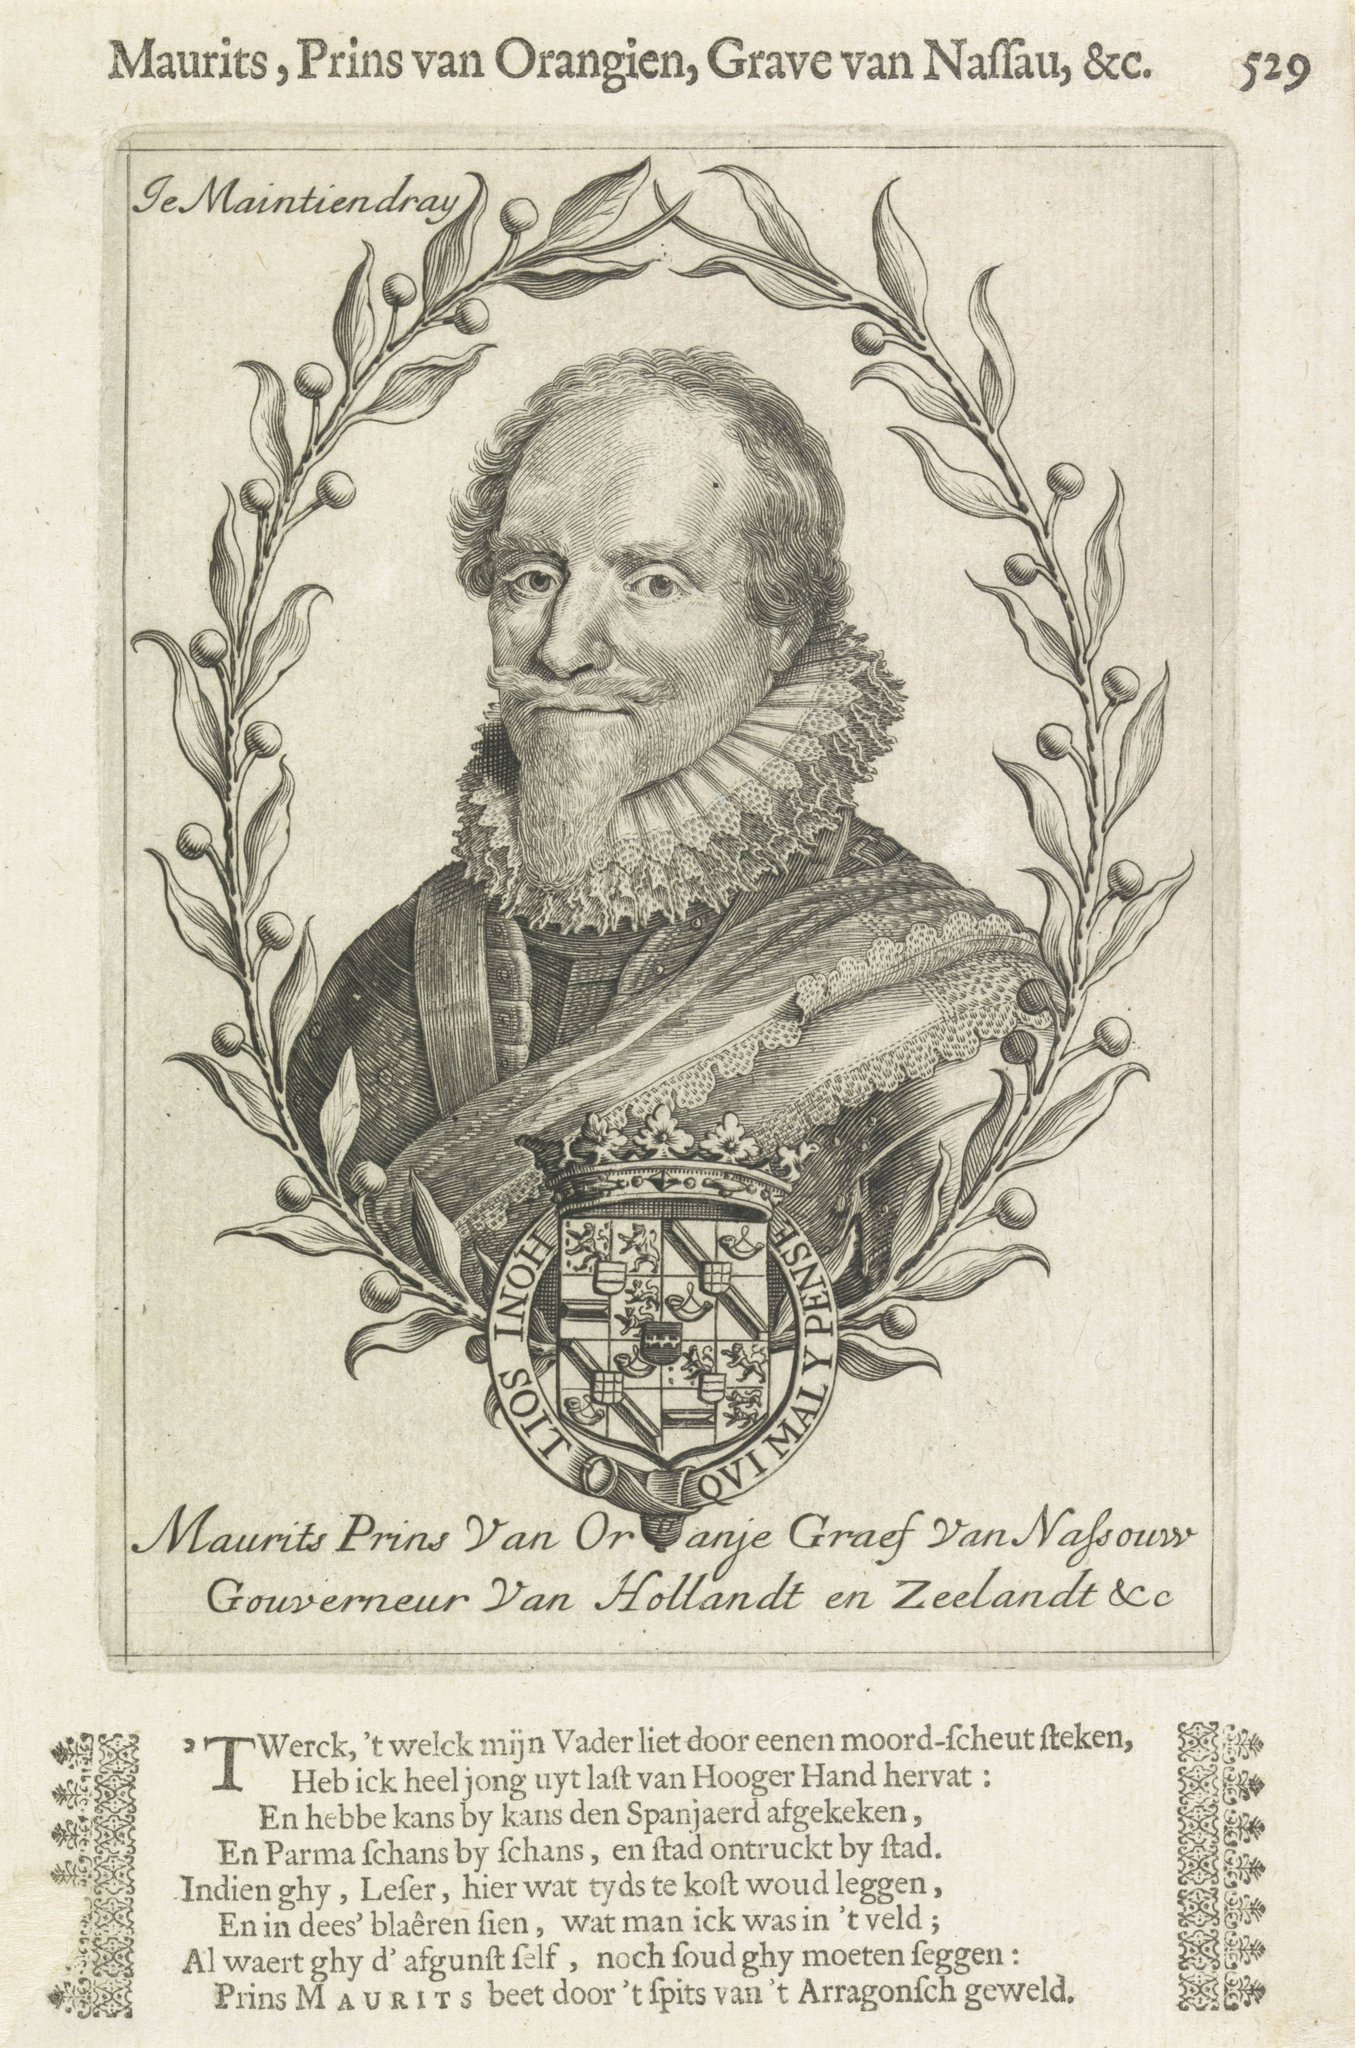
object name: book illustration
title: Portret van Maurits, prins van Oranje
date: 1667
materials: paper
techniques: engraving, etching, letterpress printing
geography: the hague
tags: maurice (prince of orange), knighthood order (garter) - insignia of a knighthood order, e.g.: badge, chain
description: De hier vermelde titel verwijst naar de hoogst verkregen titel van de geportretteerde, niet per se naar de titel die de geportretteerde op deze voorstelling draagt. Prent uit: Scriverius, Petrus. Oude en nieuwe beschryvinghe van Holland, Zeeland en Vriesland. Den Haag: Levijn van Dijck, 1667.